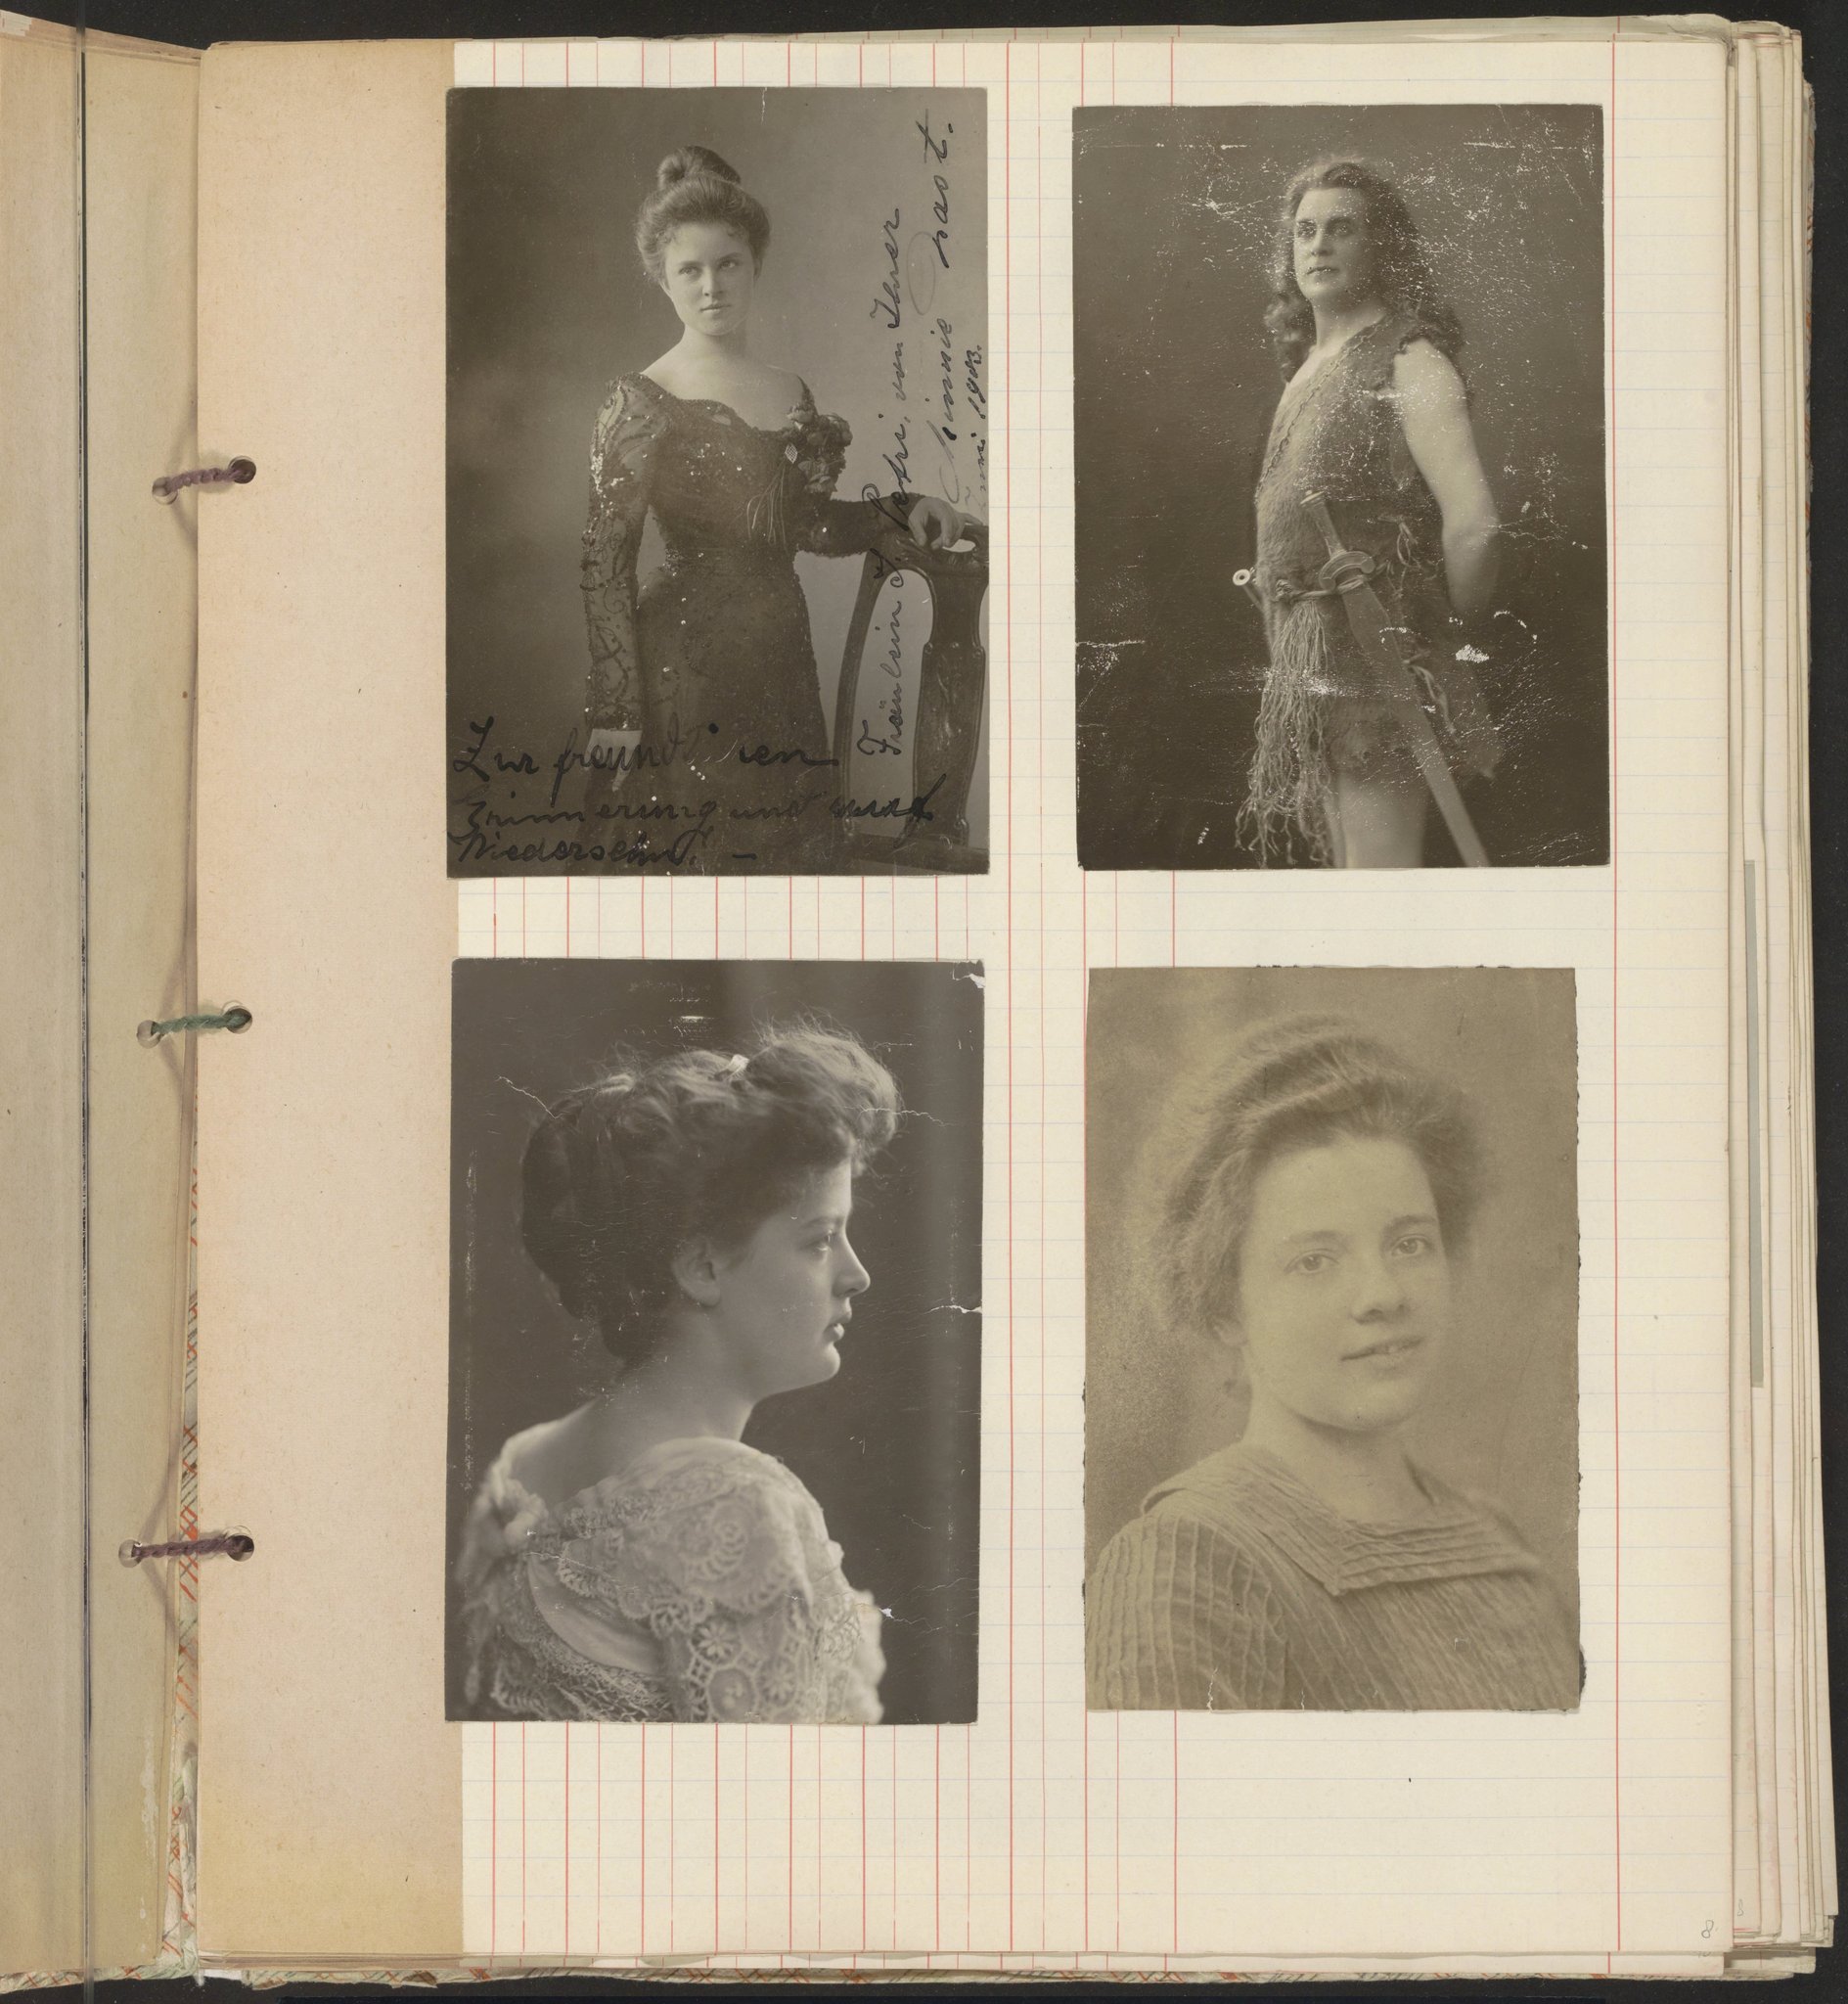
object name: photograph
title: Portretten van onbekende personen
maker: Anonymous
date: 1903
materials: paper, photographic support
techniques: gelatin silver print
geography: germany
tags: adult woman, adult man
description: Albumblad met een vier portretten van jonge vrouwen en een man met zwaard en berenvel. De foto linksboven is gericht aan 'fraulein Petri'. Onderdeel van Fotoalbum van de familie Petri.